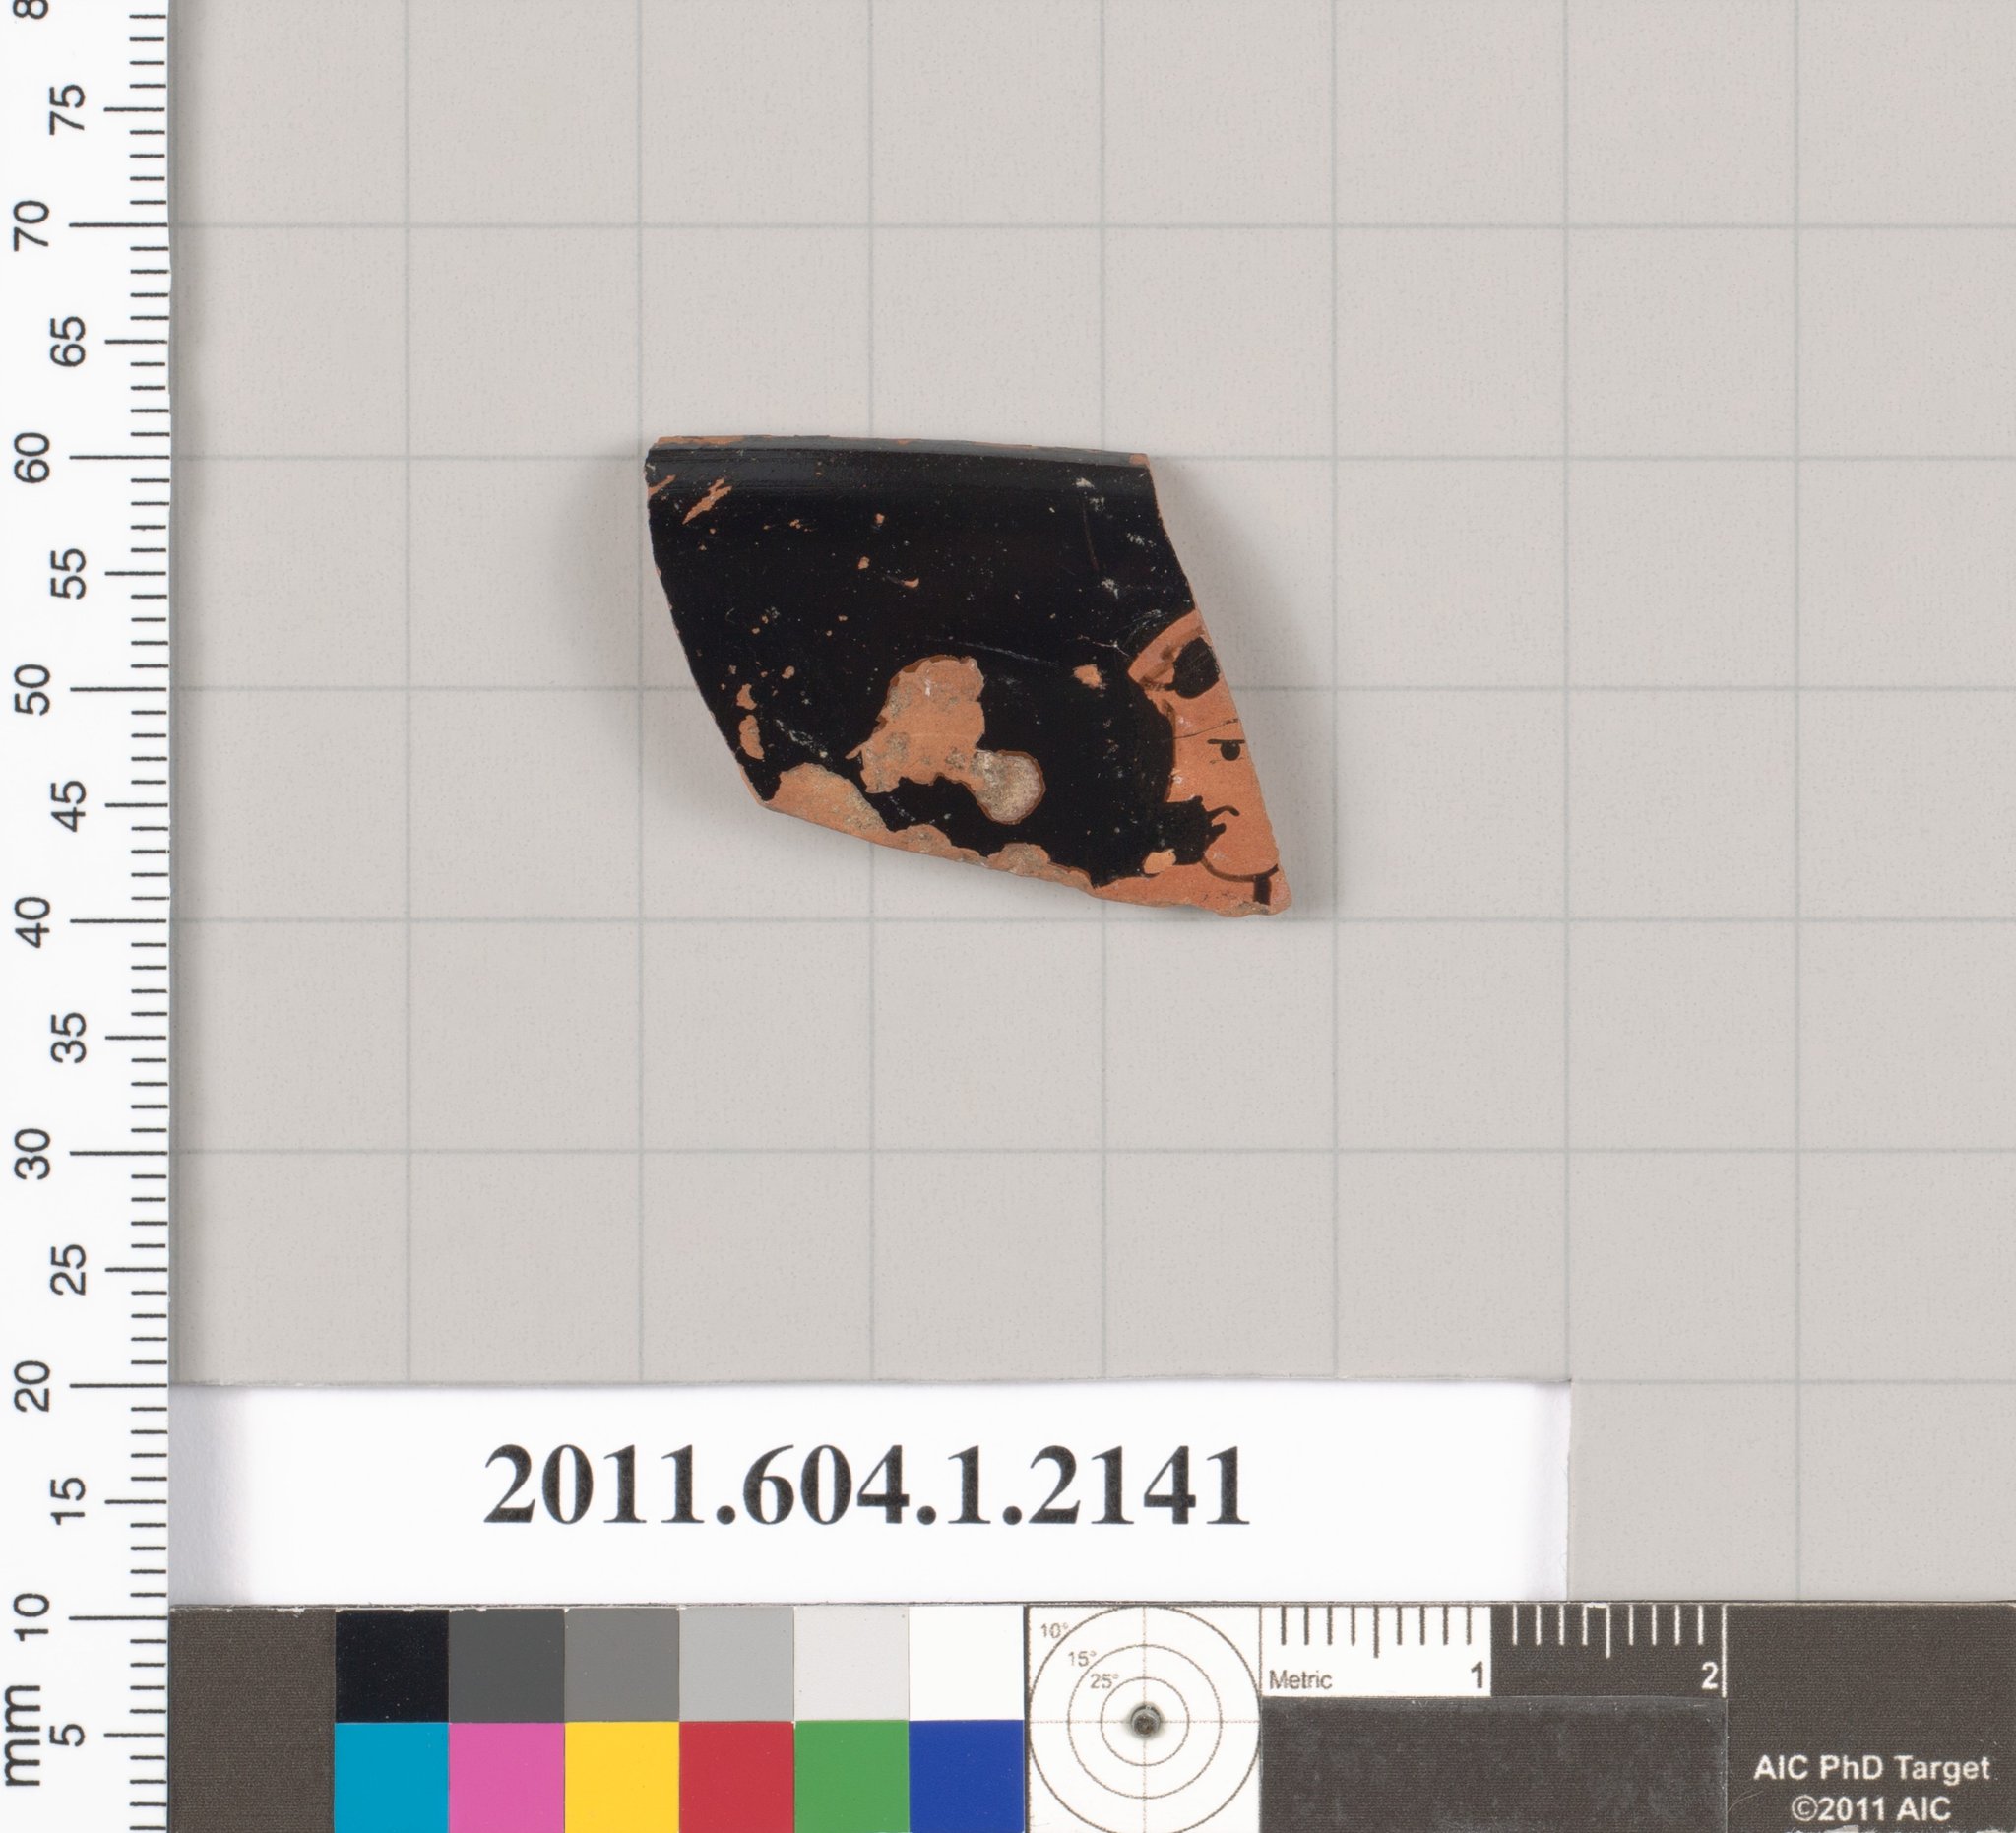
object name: kylix fragment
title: Terracotta rim fragment of a kylix (drinking cup)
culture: greek, attic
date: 467-435 BCE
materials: terracotta